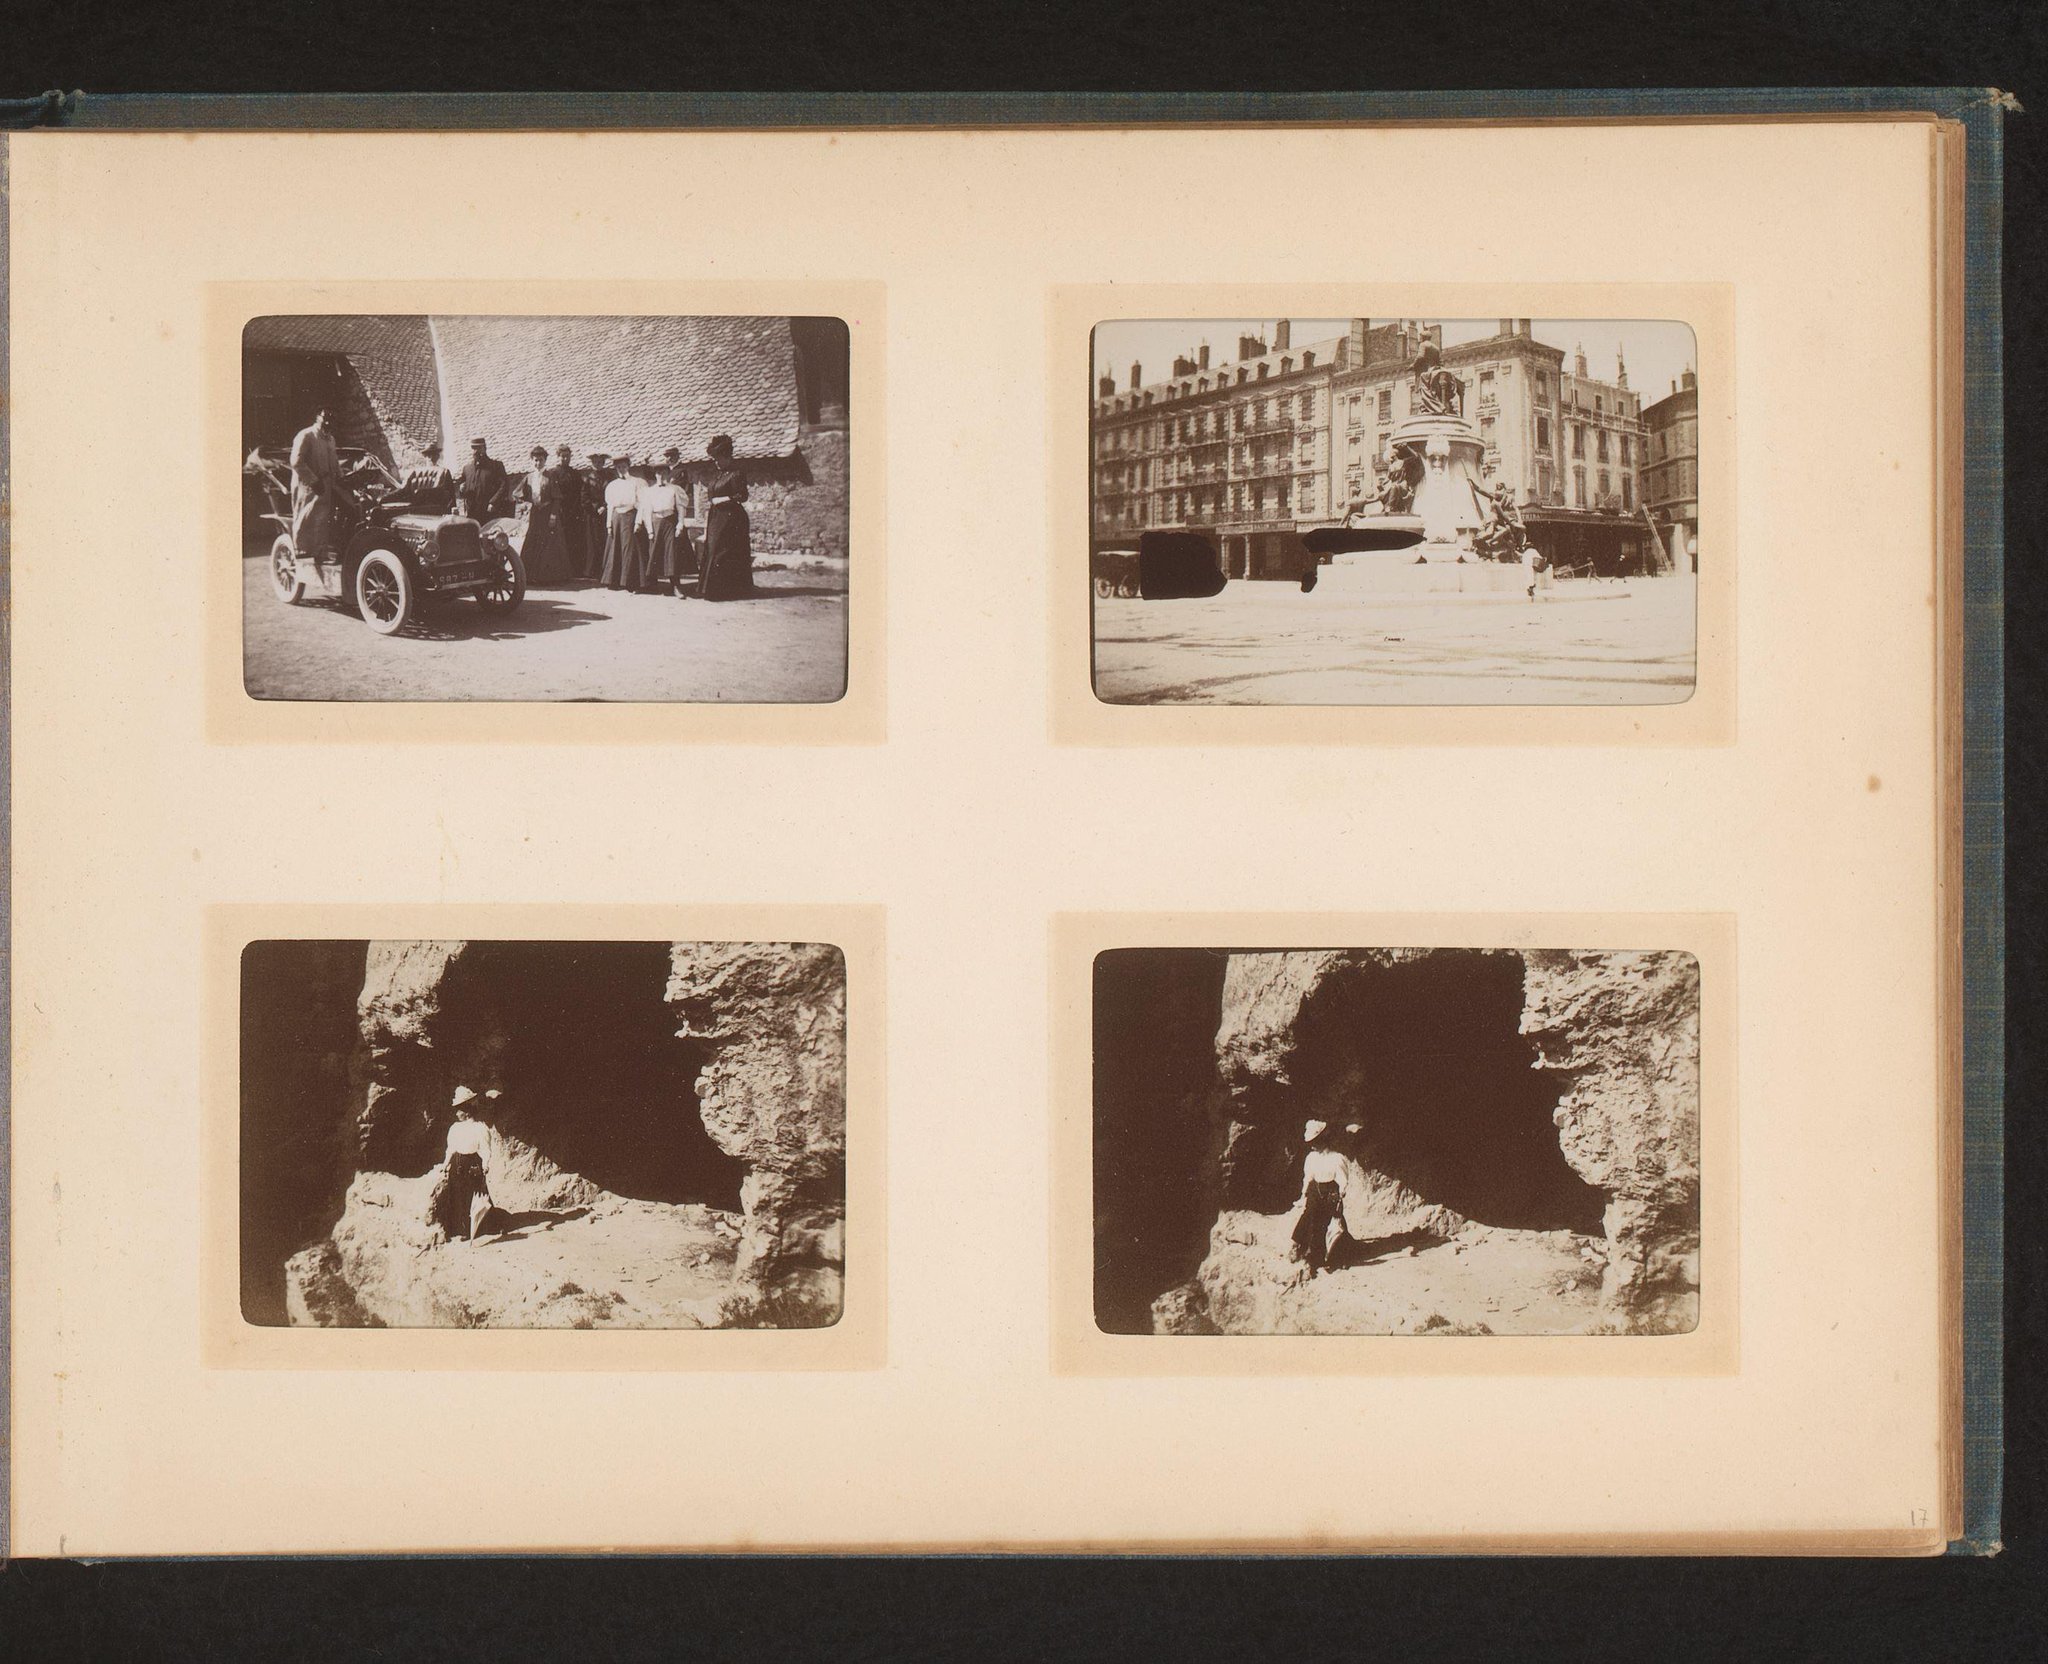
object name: photograph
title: Groepsportret bij een auto, Gezicht op een fontein en twee opnamen van een vouw bij een grot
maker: Anonymous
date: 1900-1915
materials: paper, photographic support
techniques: gelatin silver print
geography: france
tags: adult woman, cave, grotto, ornamental fountain, automobile, france